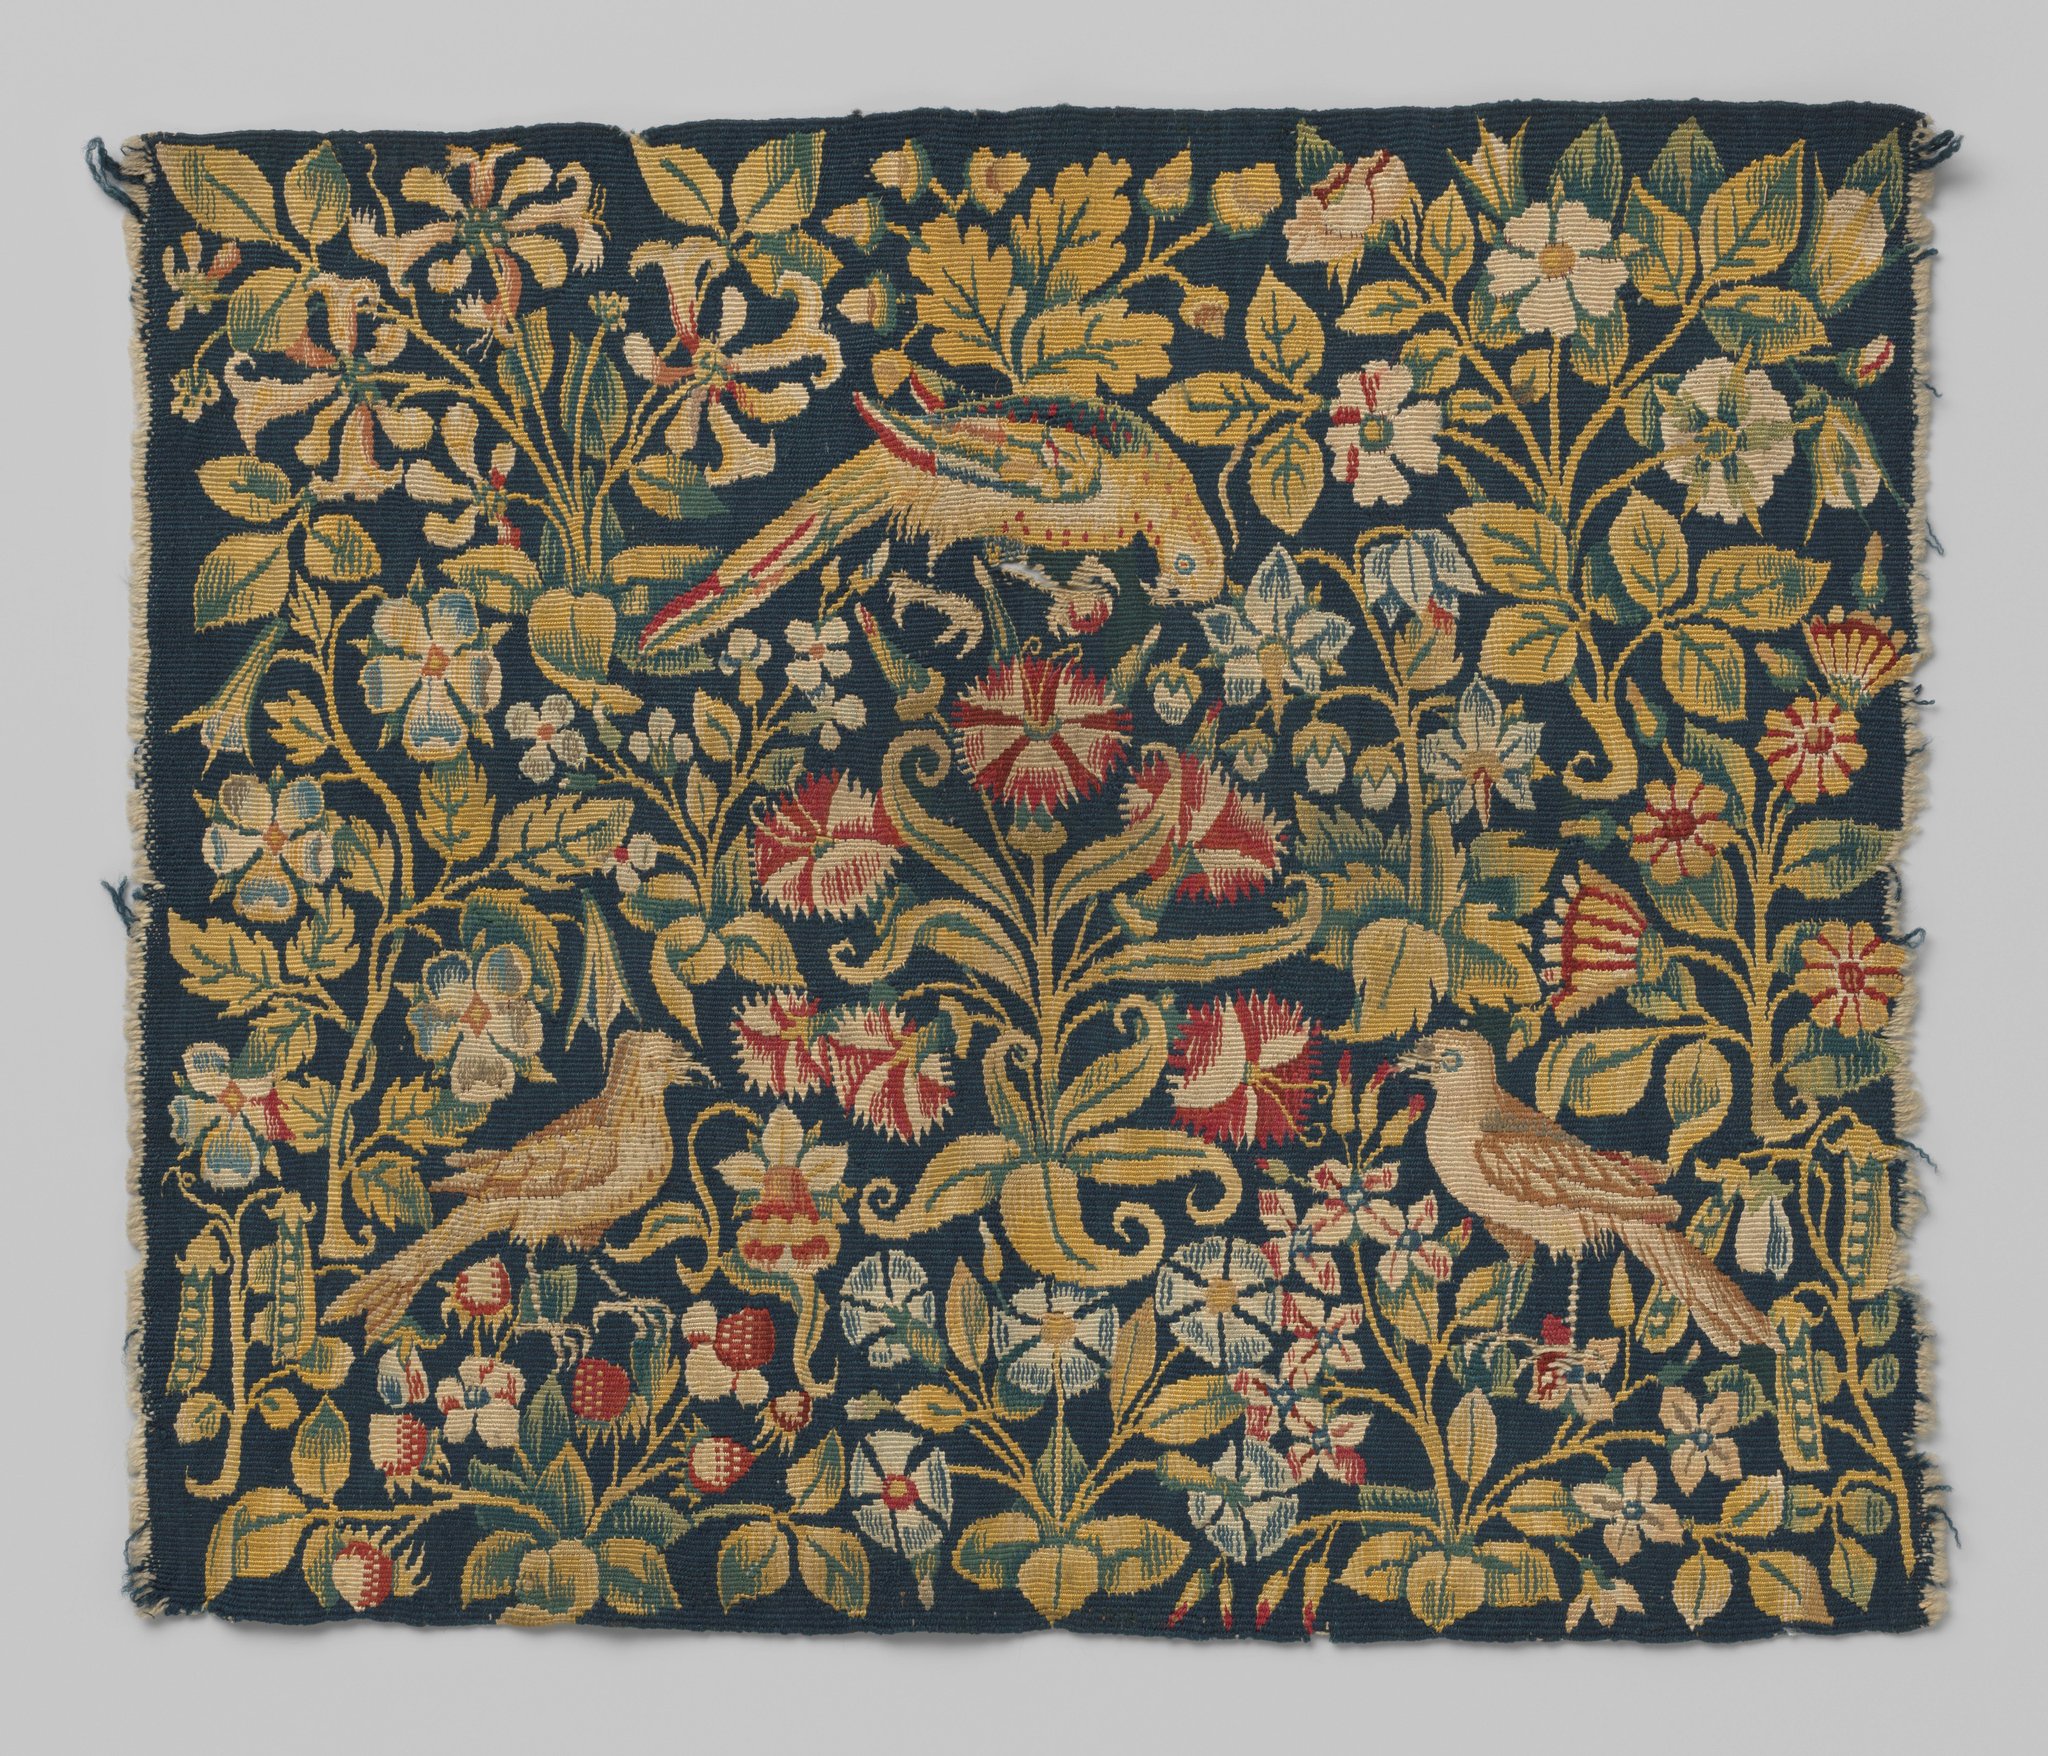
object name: stoelzitting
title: Kussenovertrek met bloemen en vogels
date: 1600-1610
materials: silk, wool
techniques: tapestry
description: Stoelzitting van tapijtweefsel met gezaaide bloemen en drie vogels.